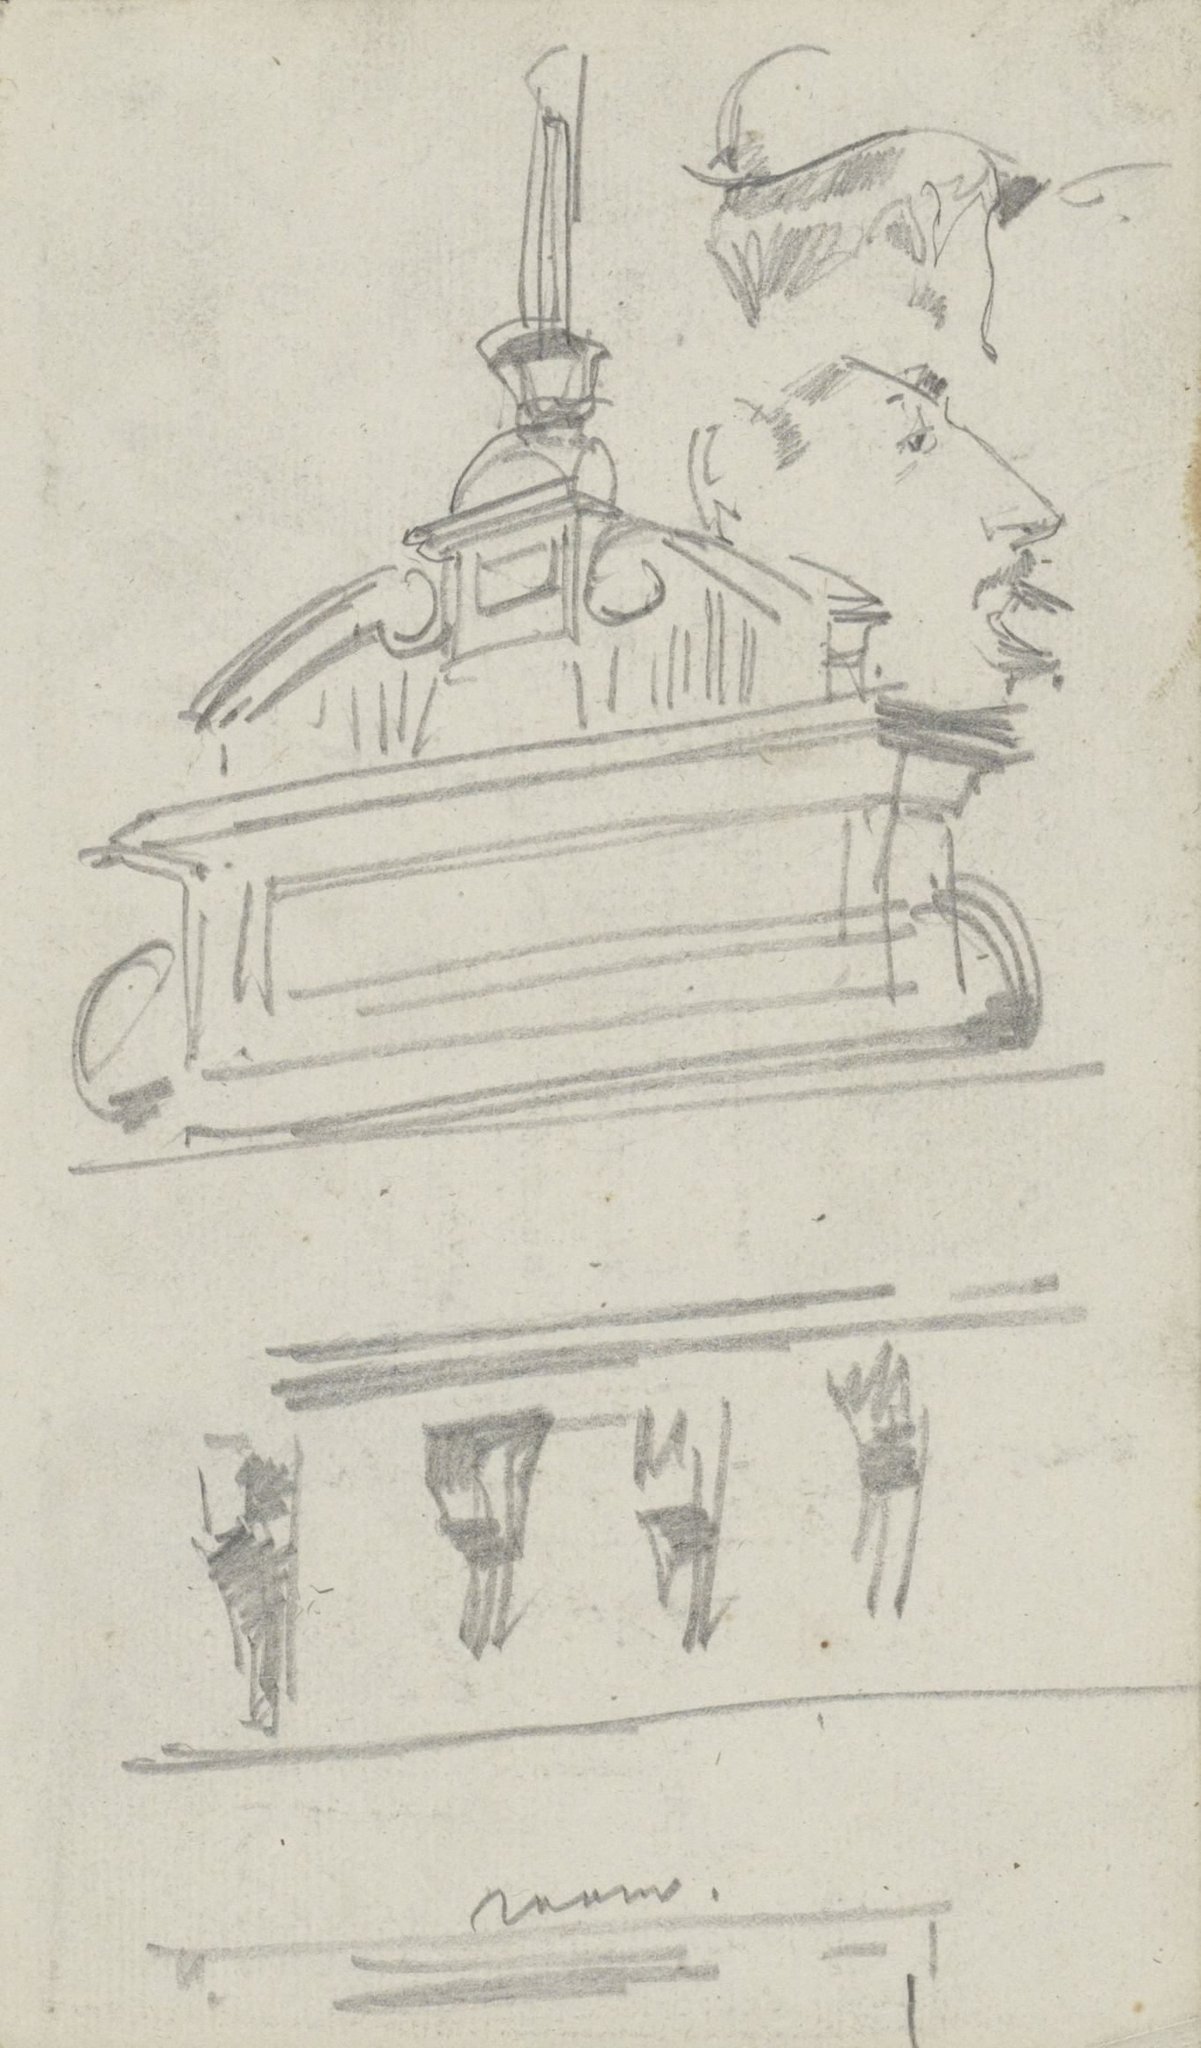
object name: drawing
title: Gevel en twee mannenhoofden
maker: george hendrik breitner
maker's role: draughtsman, painter, print maker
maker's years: 1857-1923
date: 1882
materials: paper, pencil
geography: rotterdam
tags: head (human), façade (of house or building)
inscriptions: annotation: ‘raam’